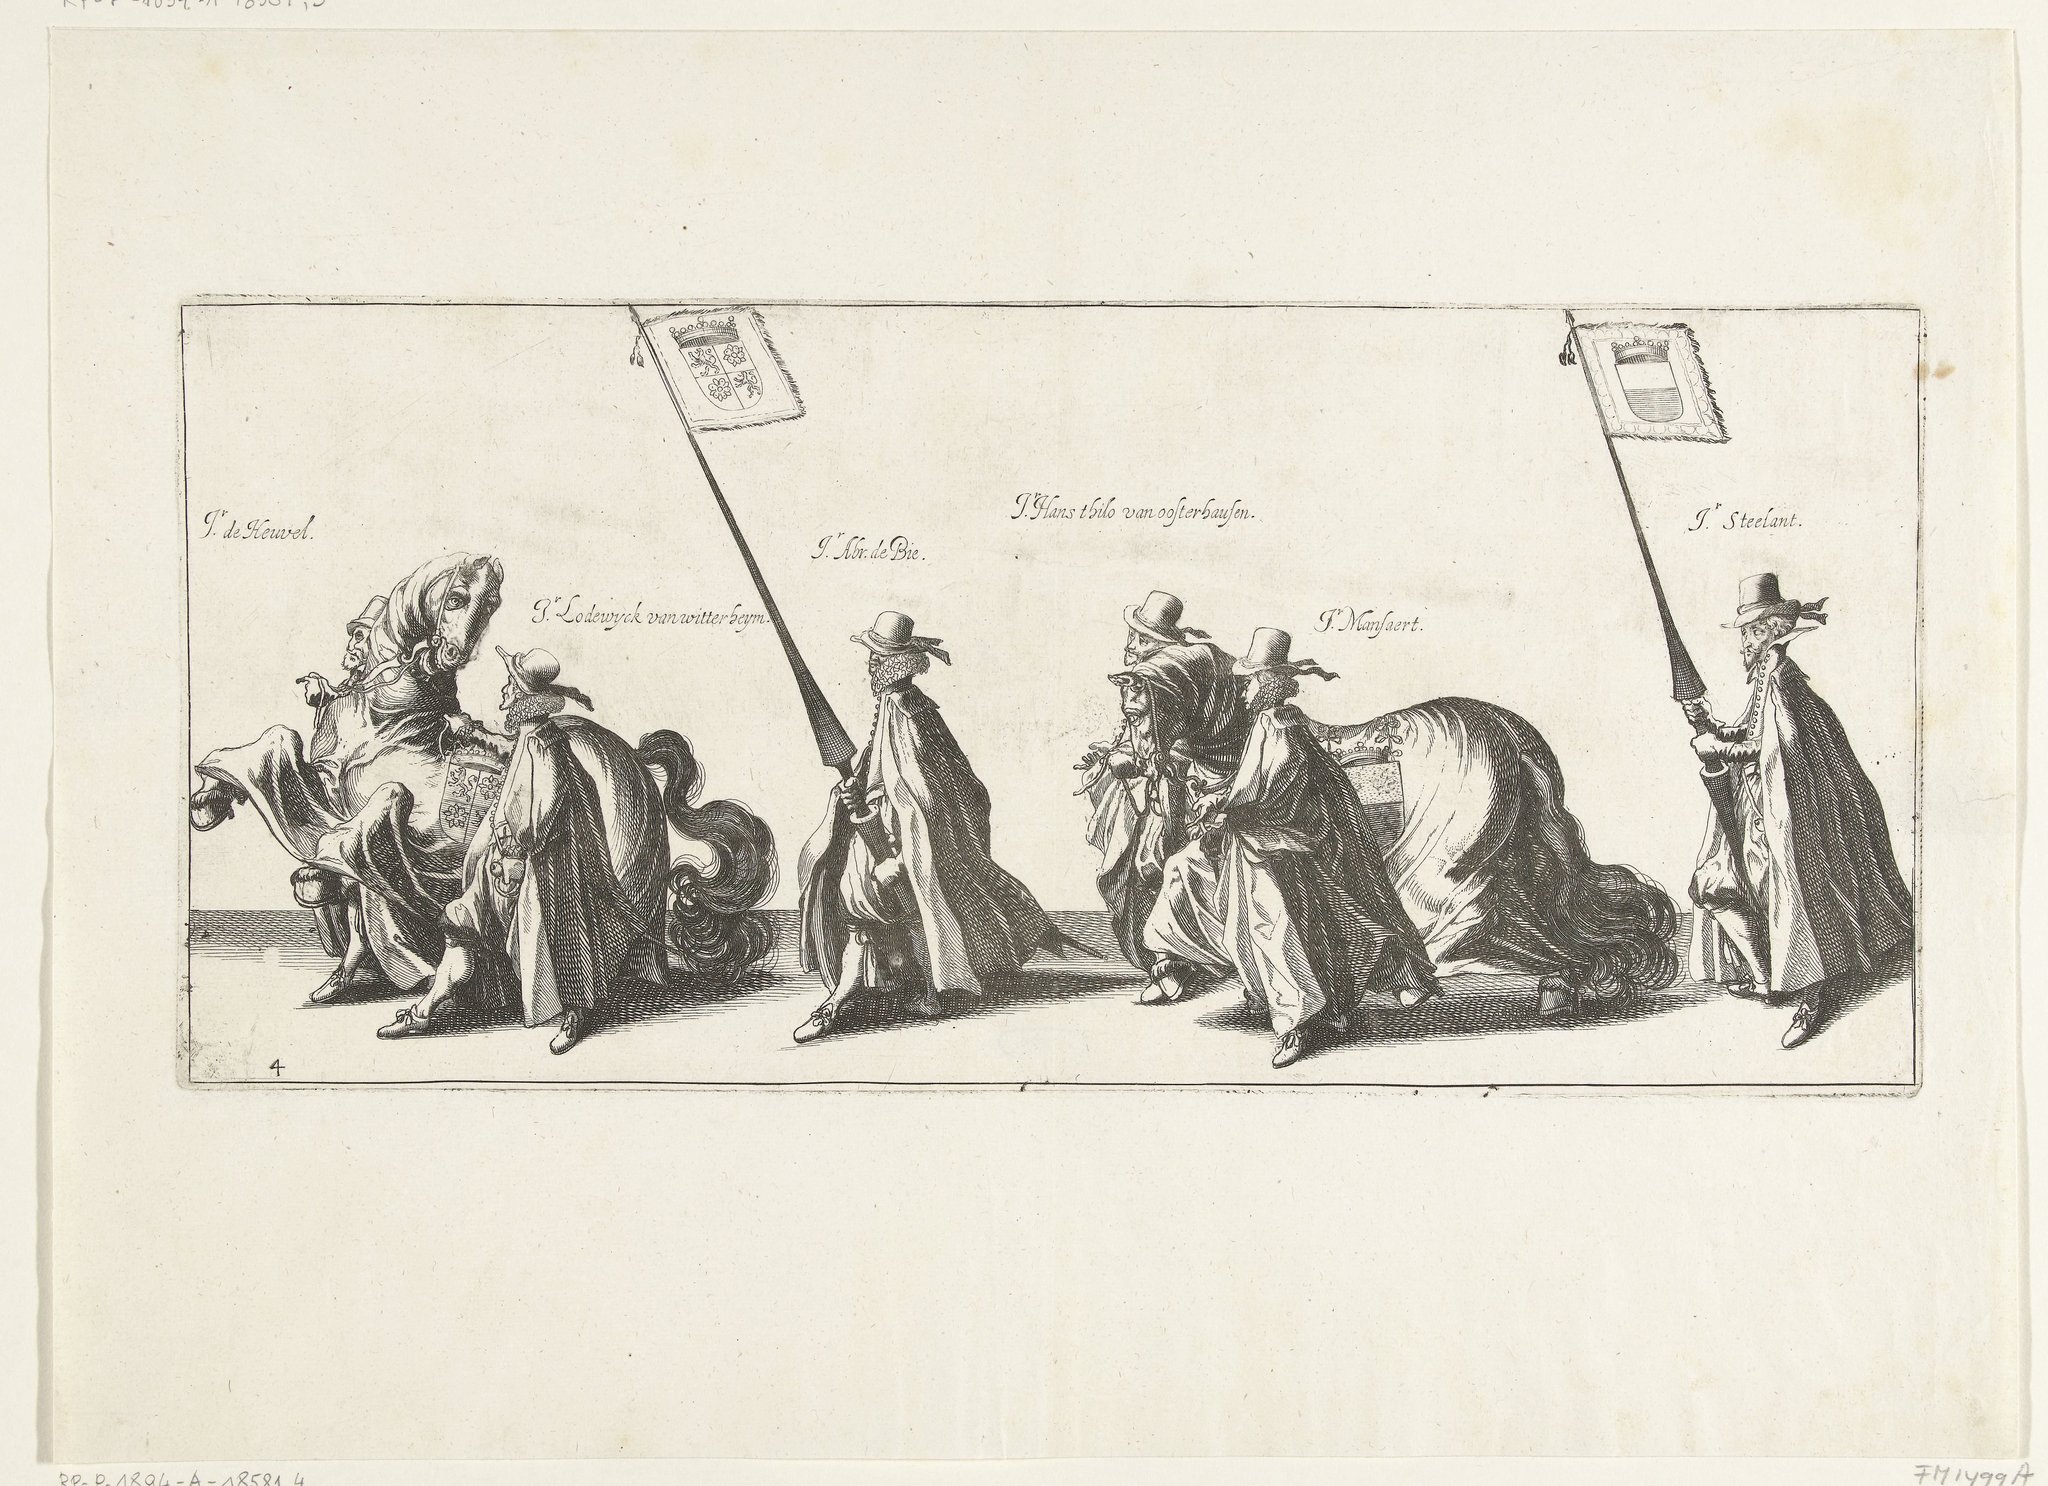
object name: print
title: De begrafenisstoet (plaat 4), 1623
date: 1615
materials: paper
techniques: etching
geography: northern netherlands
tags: cortege, funeral procession, the hague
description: De begrafenisstoet (plaat 4).Twee paarden en twee banieren. Onderdeel van de serie prenten van de begrafenisoptocht van Johann Albrecht, graaf van Solms, op 25 mei 1623 te Den Haag.